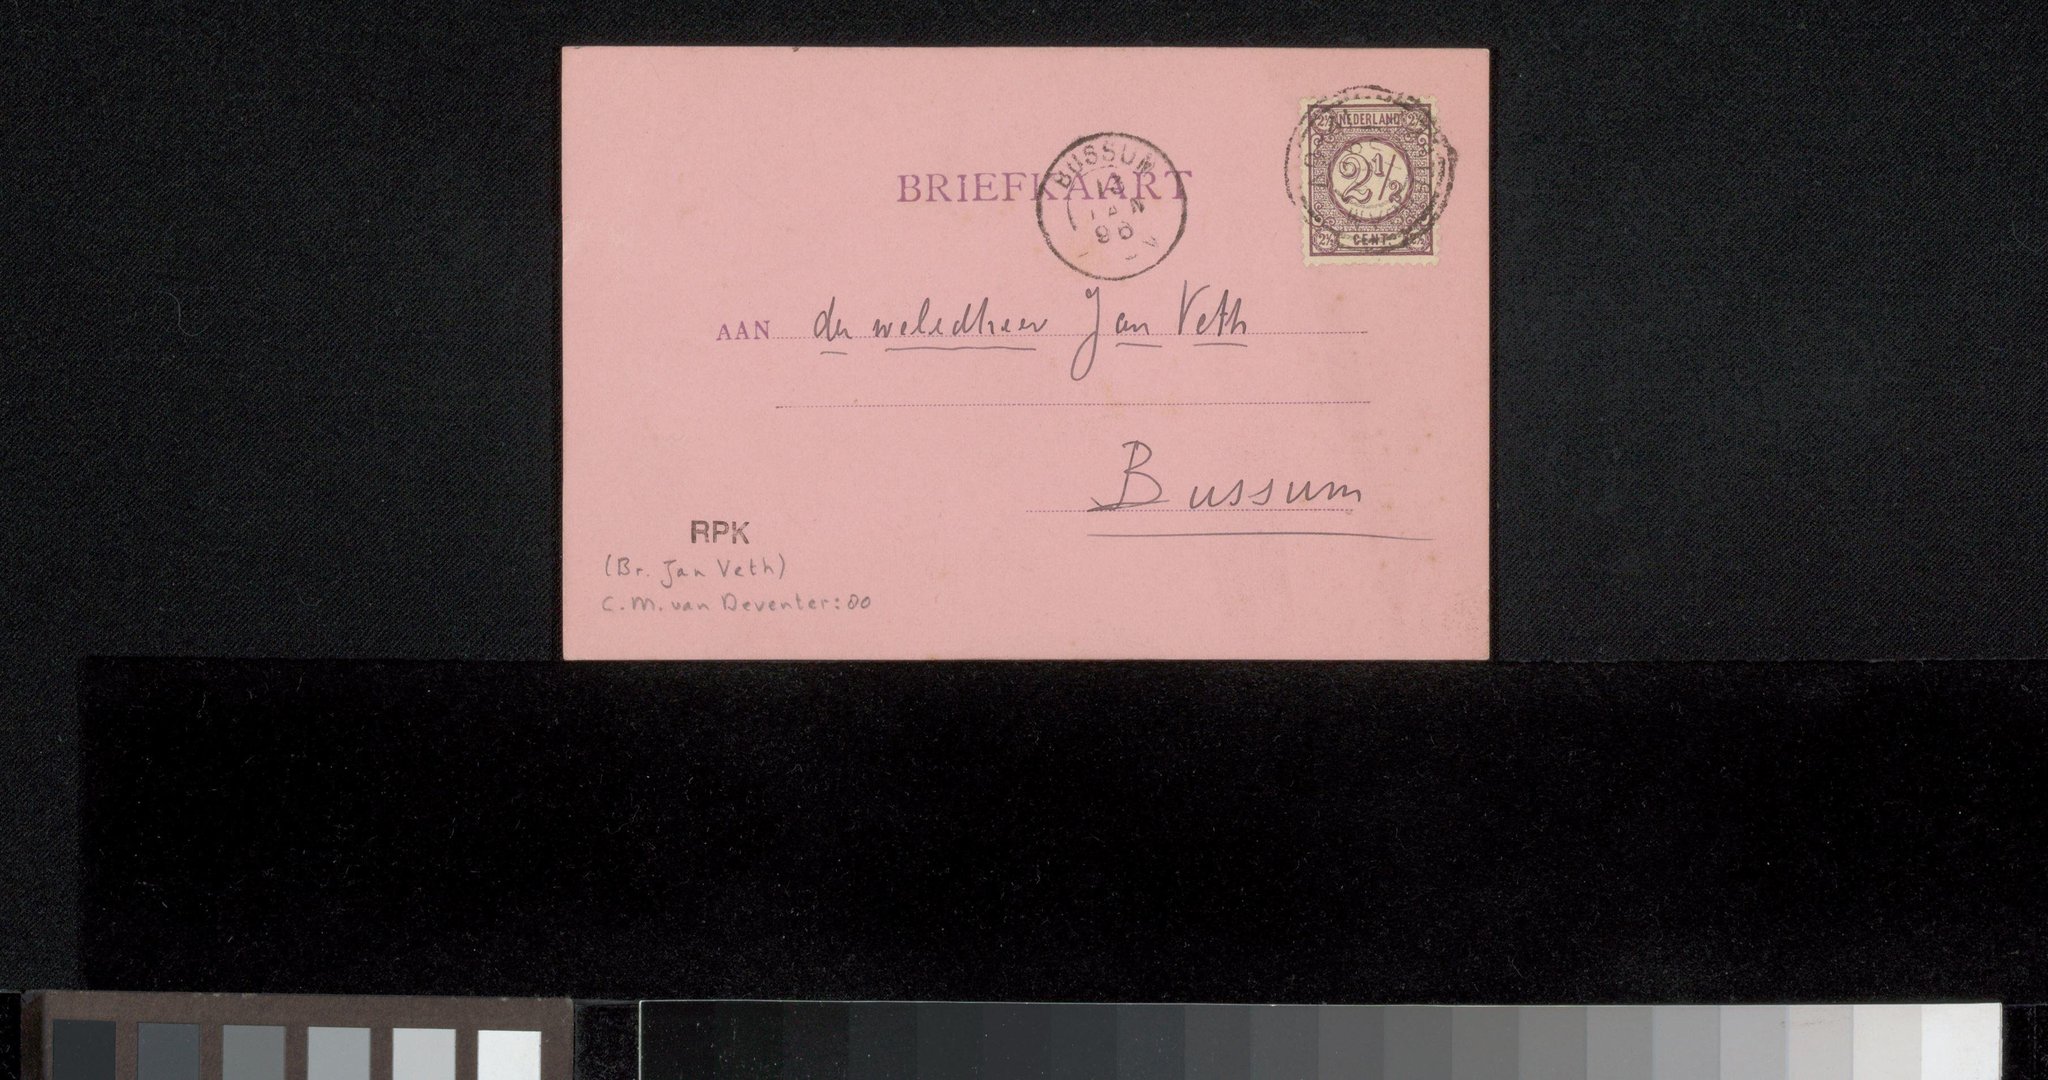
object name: postcard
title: Briefkaart aan Jan Veth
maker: chap van deventer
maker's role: kunstcriticus, scheikundige, schrijver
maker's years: 1860-1931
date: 1896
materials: cardboard, ink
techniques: pen, writing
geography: amsterdam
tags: painter, draughtsman, designer, jan veth, lodewijk van deyssel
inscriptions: collector's mark: ‘RPK’